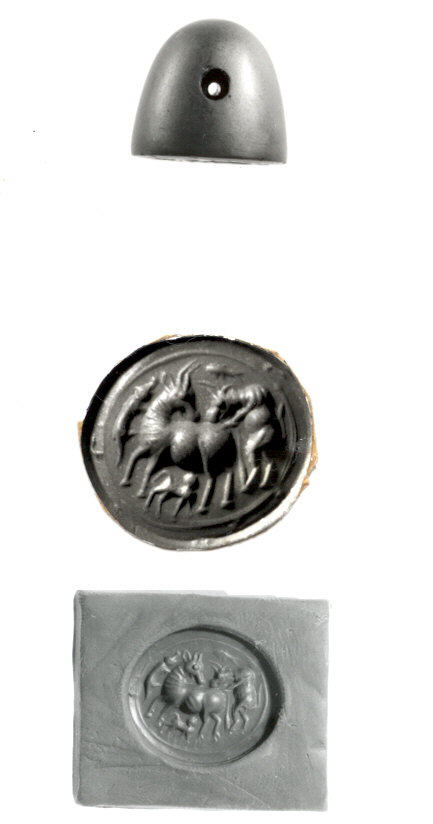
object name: stamp seal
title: Conoid stamp seal: lions (?) attacking cow suckling calf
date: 1300-1101 BCE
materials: copper alloy, mineral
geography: cyprus (?)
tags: animals